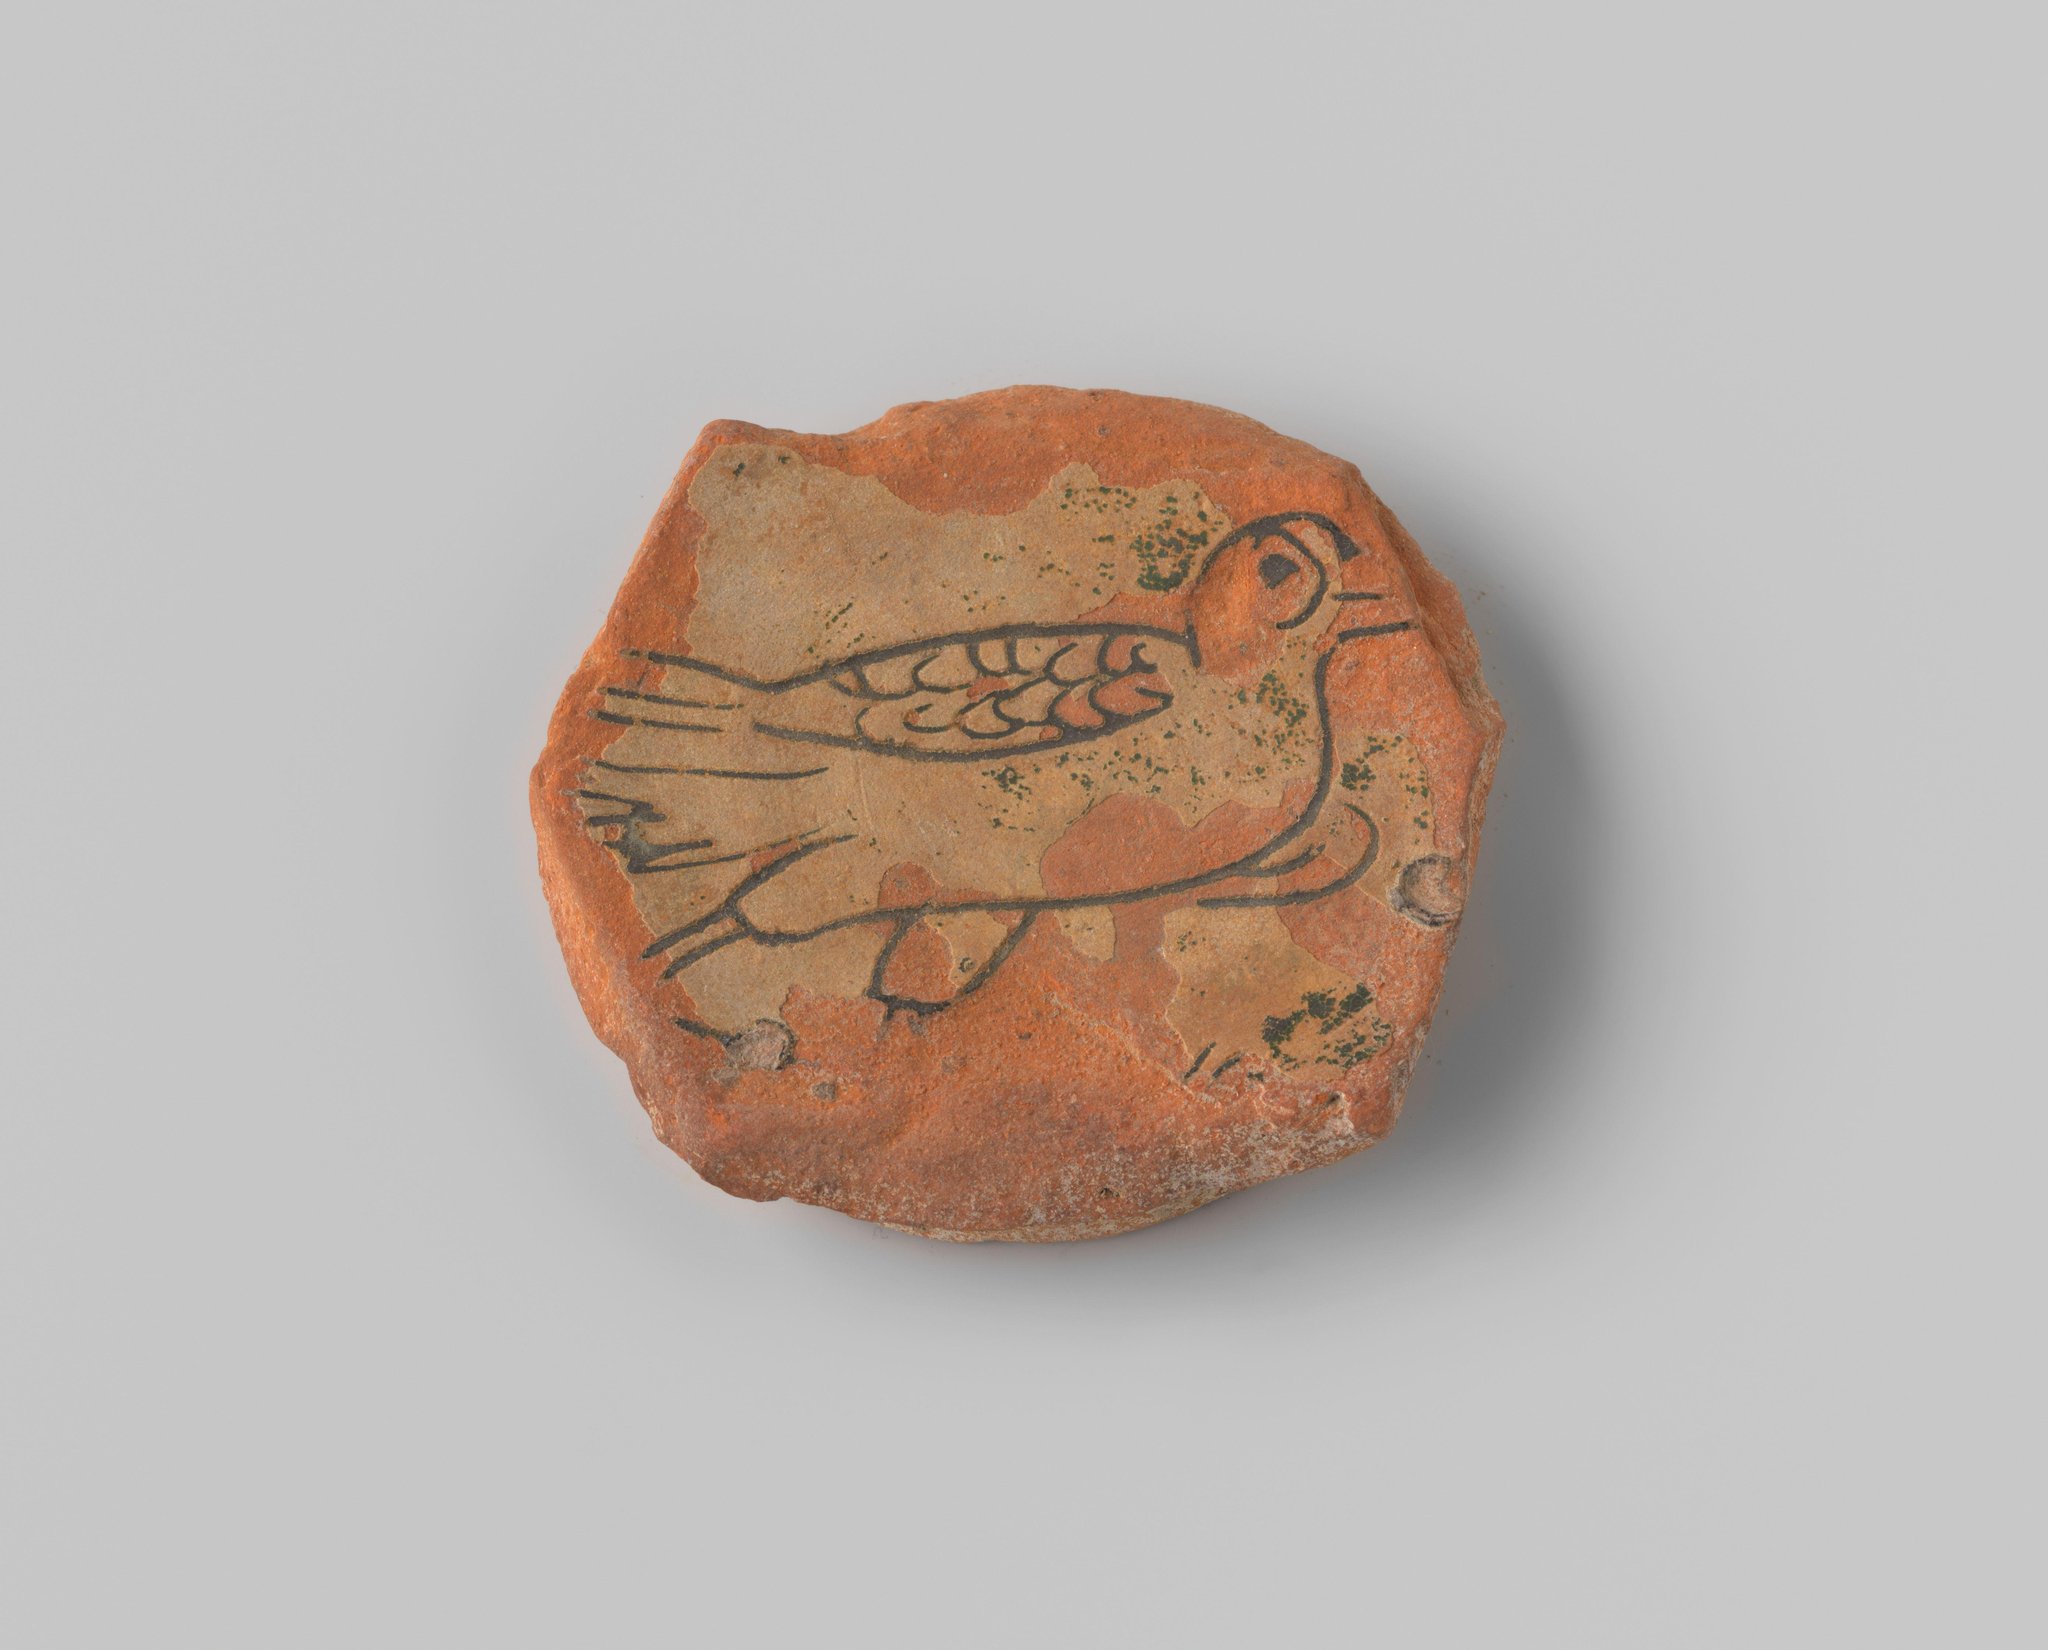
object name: sherd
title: Fragment (voet) met rode scherf, aan de binnenkant in sgraffito-techniek met zwarte lijnen een vogel op een beige fond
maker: Anonymous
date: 1200-1899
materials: earthenware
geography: italy